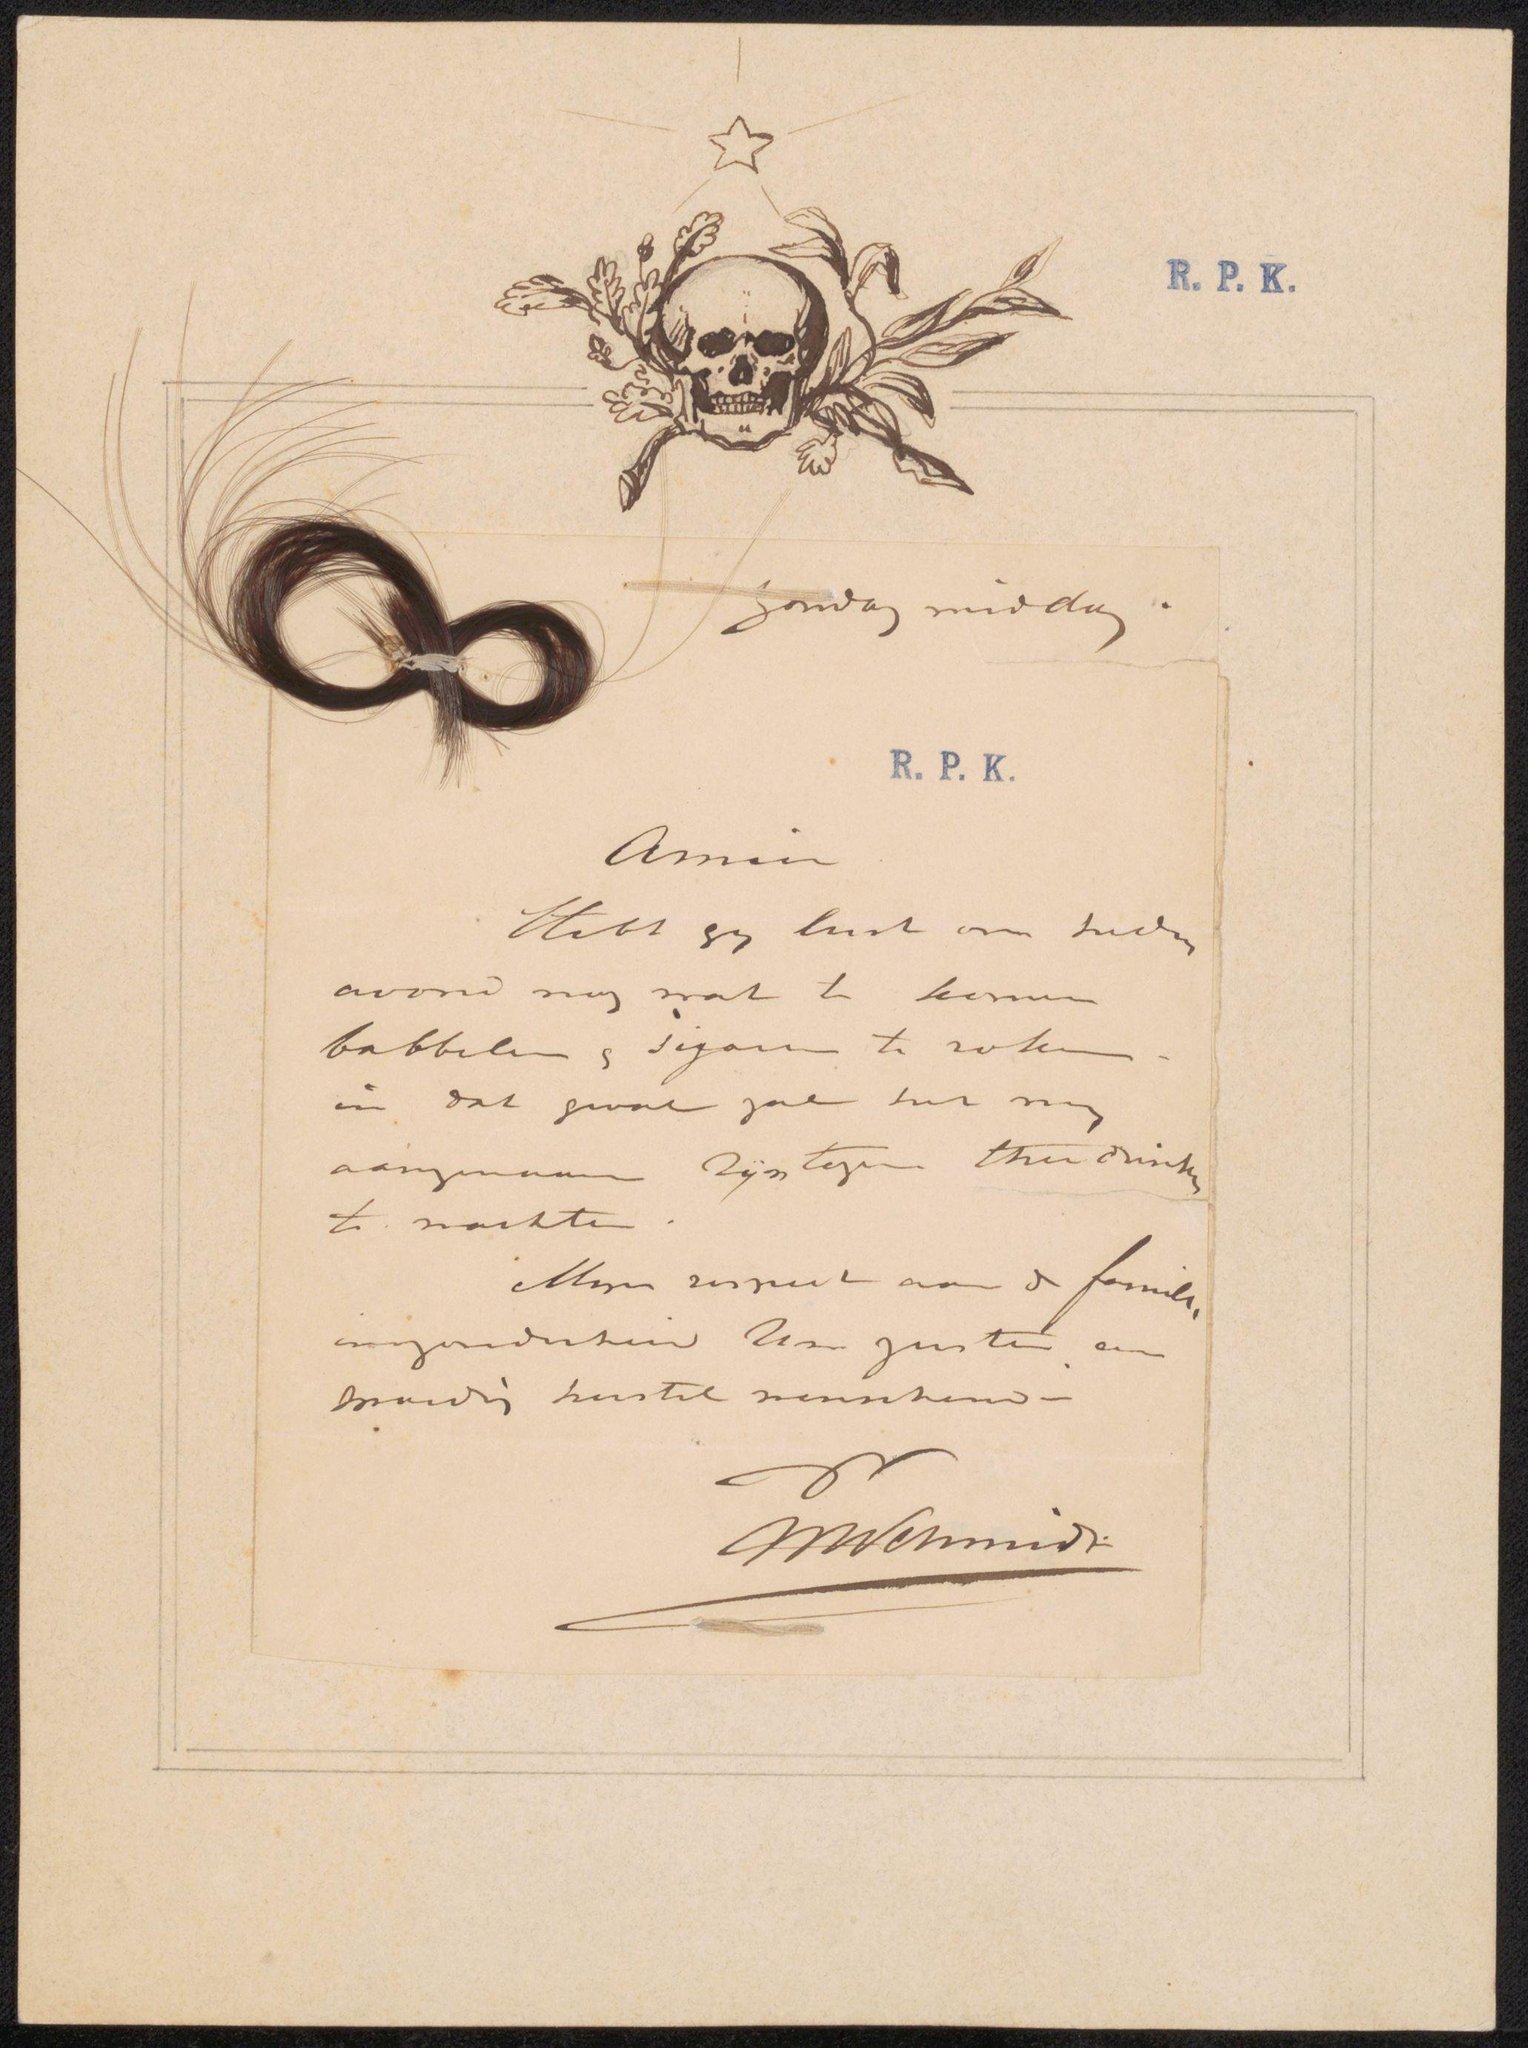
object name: letter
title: Brief aan Karel Frederik Bombled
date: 1832-1849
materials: ink, paper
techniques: pen, writing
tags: amsterdam, chantilly, draughtsman, karel frederik bombled, death's head, skull (symbol of death)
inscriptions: annotation: ‘van Ch Bombled, leerling van WH Schmidt 19 february 1884’, collector's mark: Lugt 2233